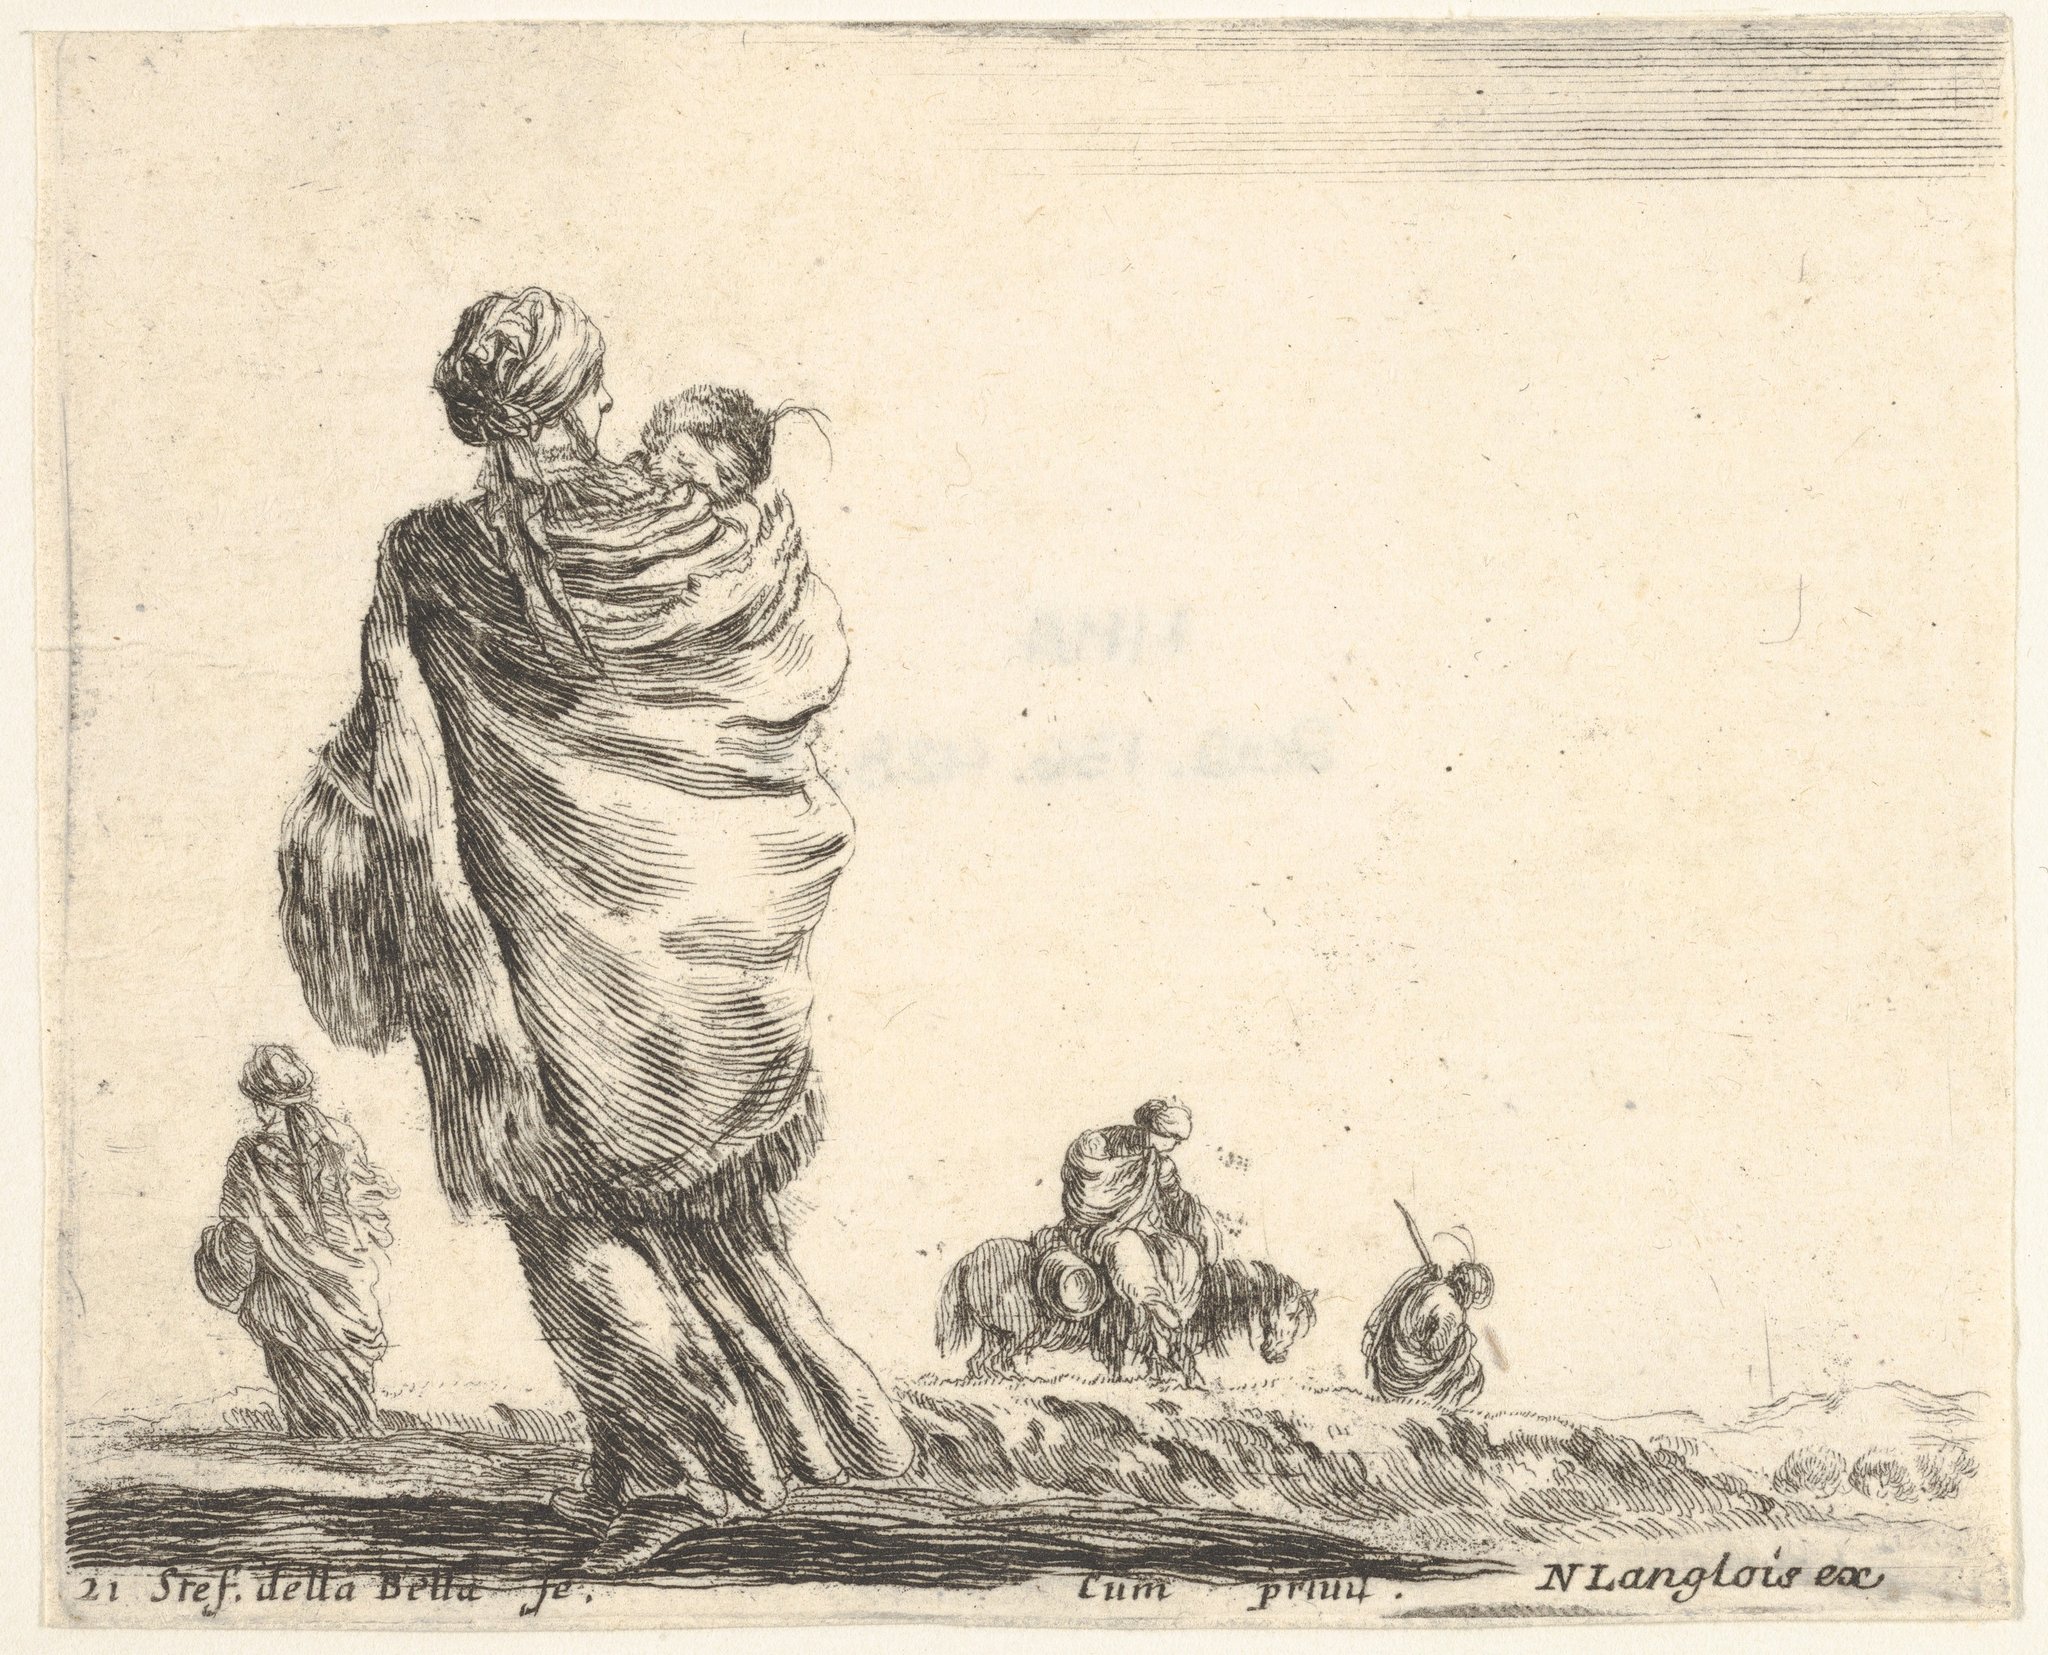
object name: print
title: Plate 21: a poor woman to left, seen from behind, enveloping her child in a shawl, another woman seen from behind to left in background, a woman atop a horse and a man to right in background, from "Diversi Capricci"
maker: stefano della bella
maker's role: artist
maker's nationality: italian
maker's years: 1610-1664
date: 1644-1647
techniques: etching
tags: men,women,horses